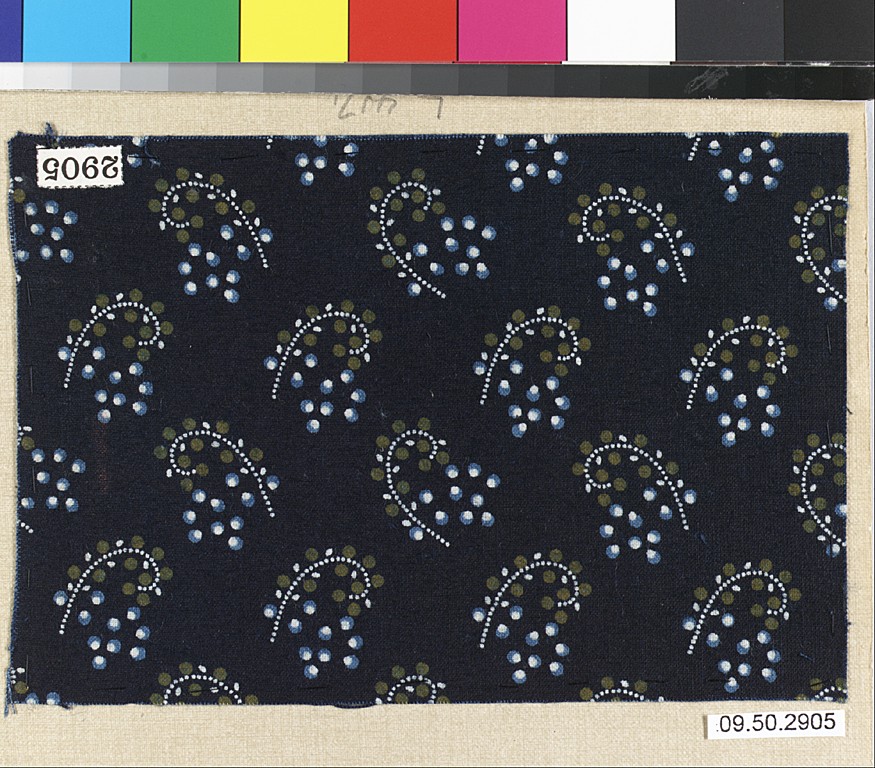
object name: piece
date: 1801-1900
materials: cotton